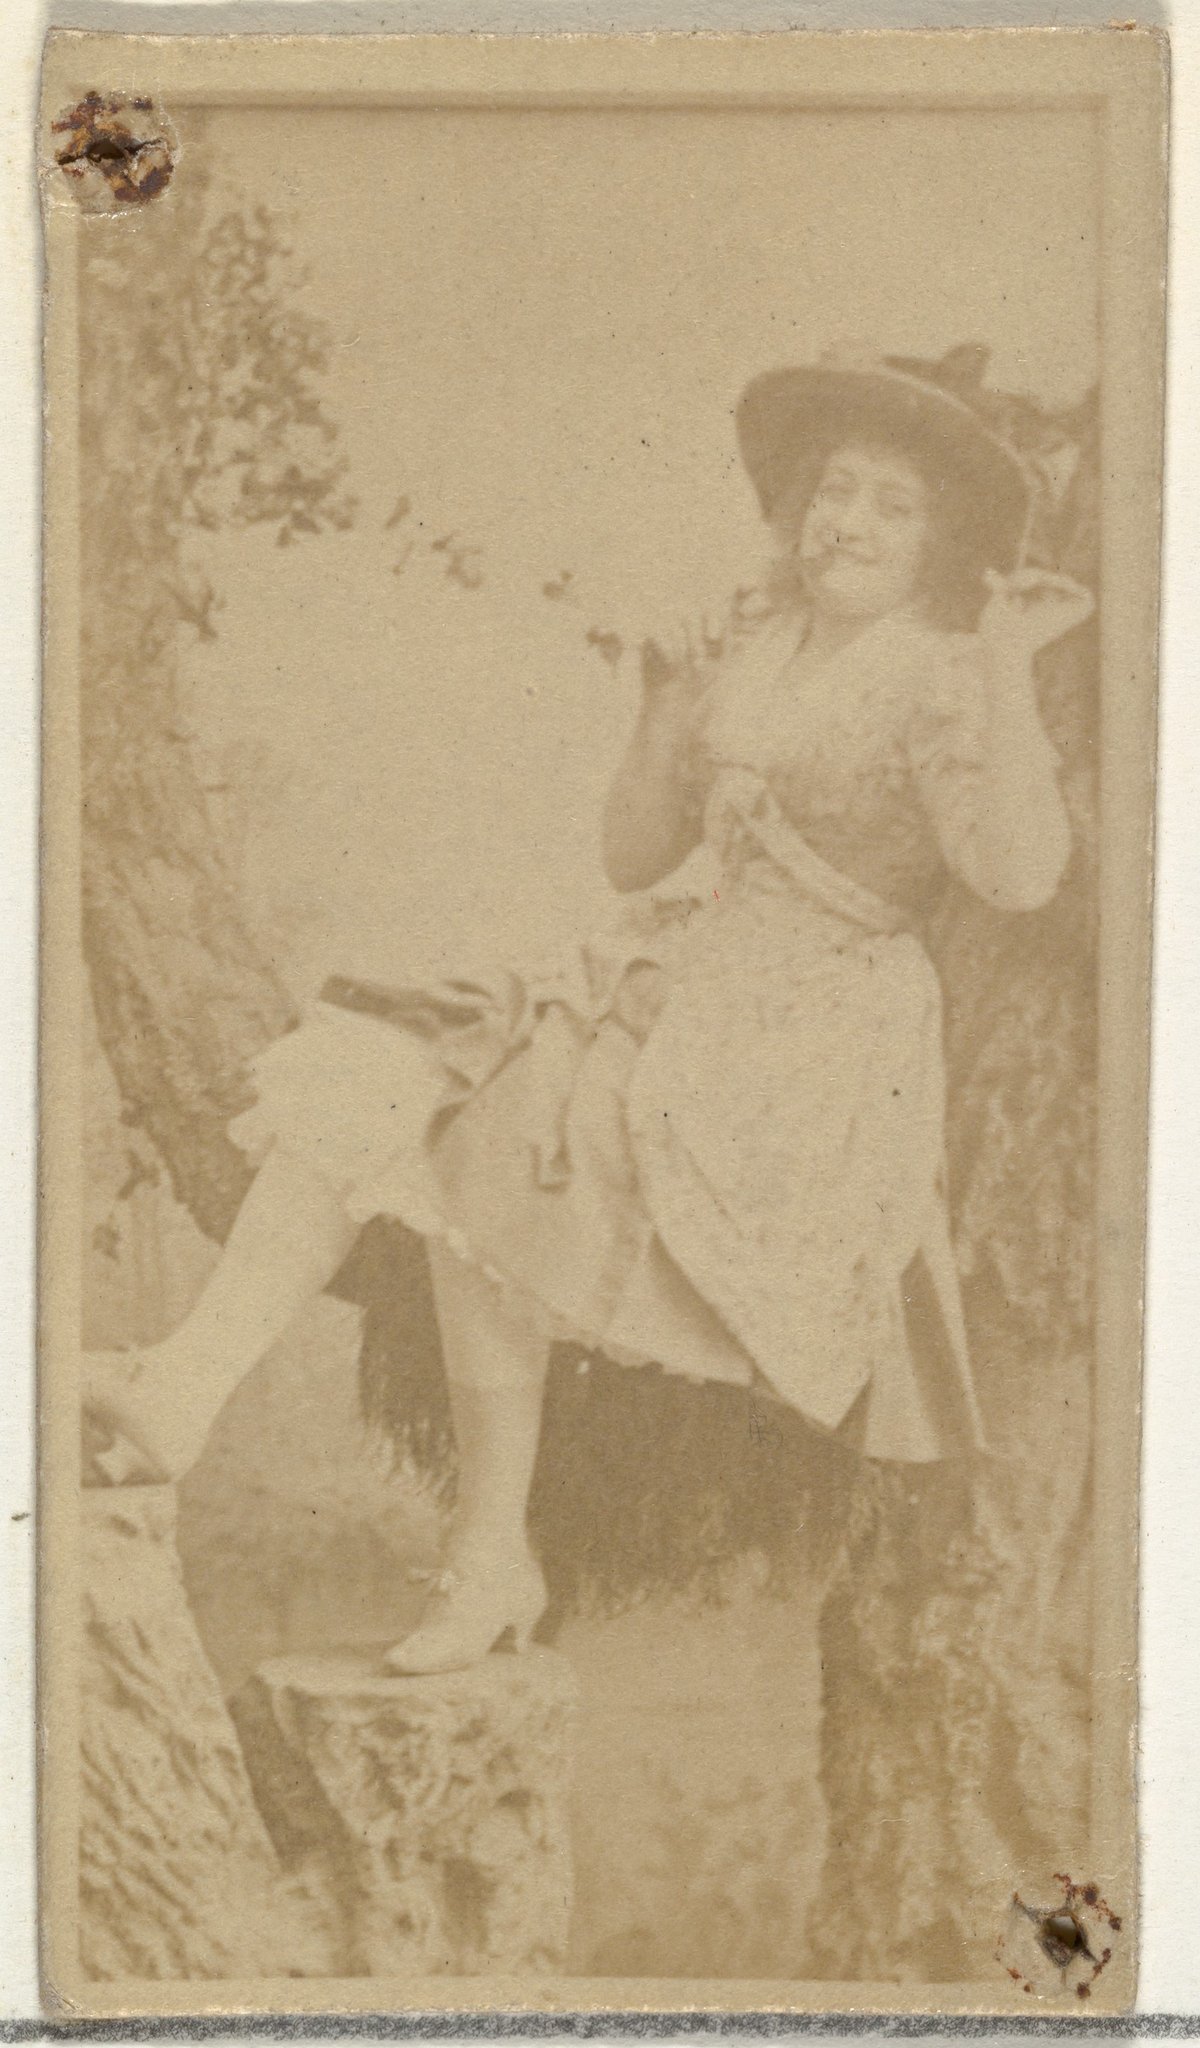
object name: photograph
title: [Actress in studio reclining against prop trees], from the Actors and Actresses series (N145-8) issued by Duke Sons & Co. to promote Duke Cigarettes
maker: w. duke, sons & co.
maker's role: publisher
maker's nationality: american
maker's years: 1870-1920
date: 1891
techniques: albumen silver print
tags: portraits,women,actresses